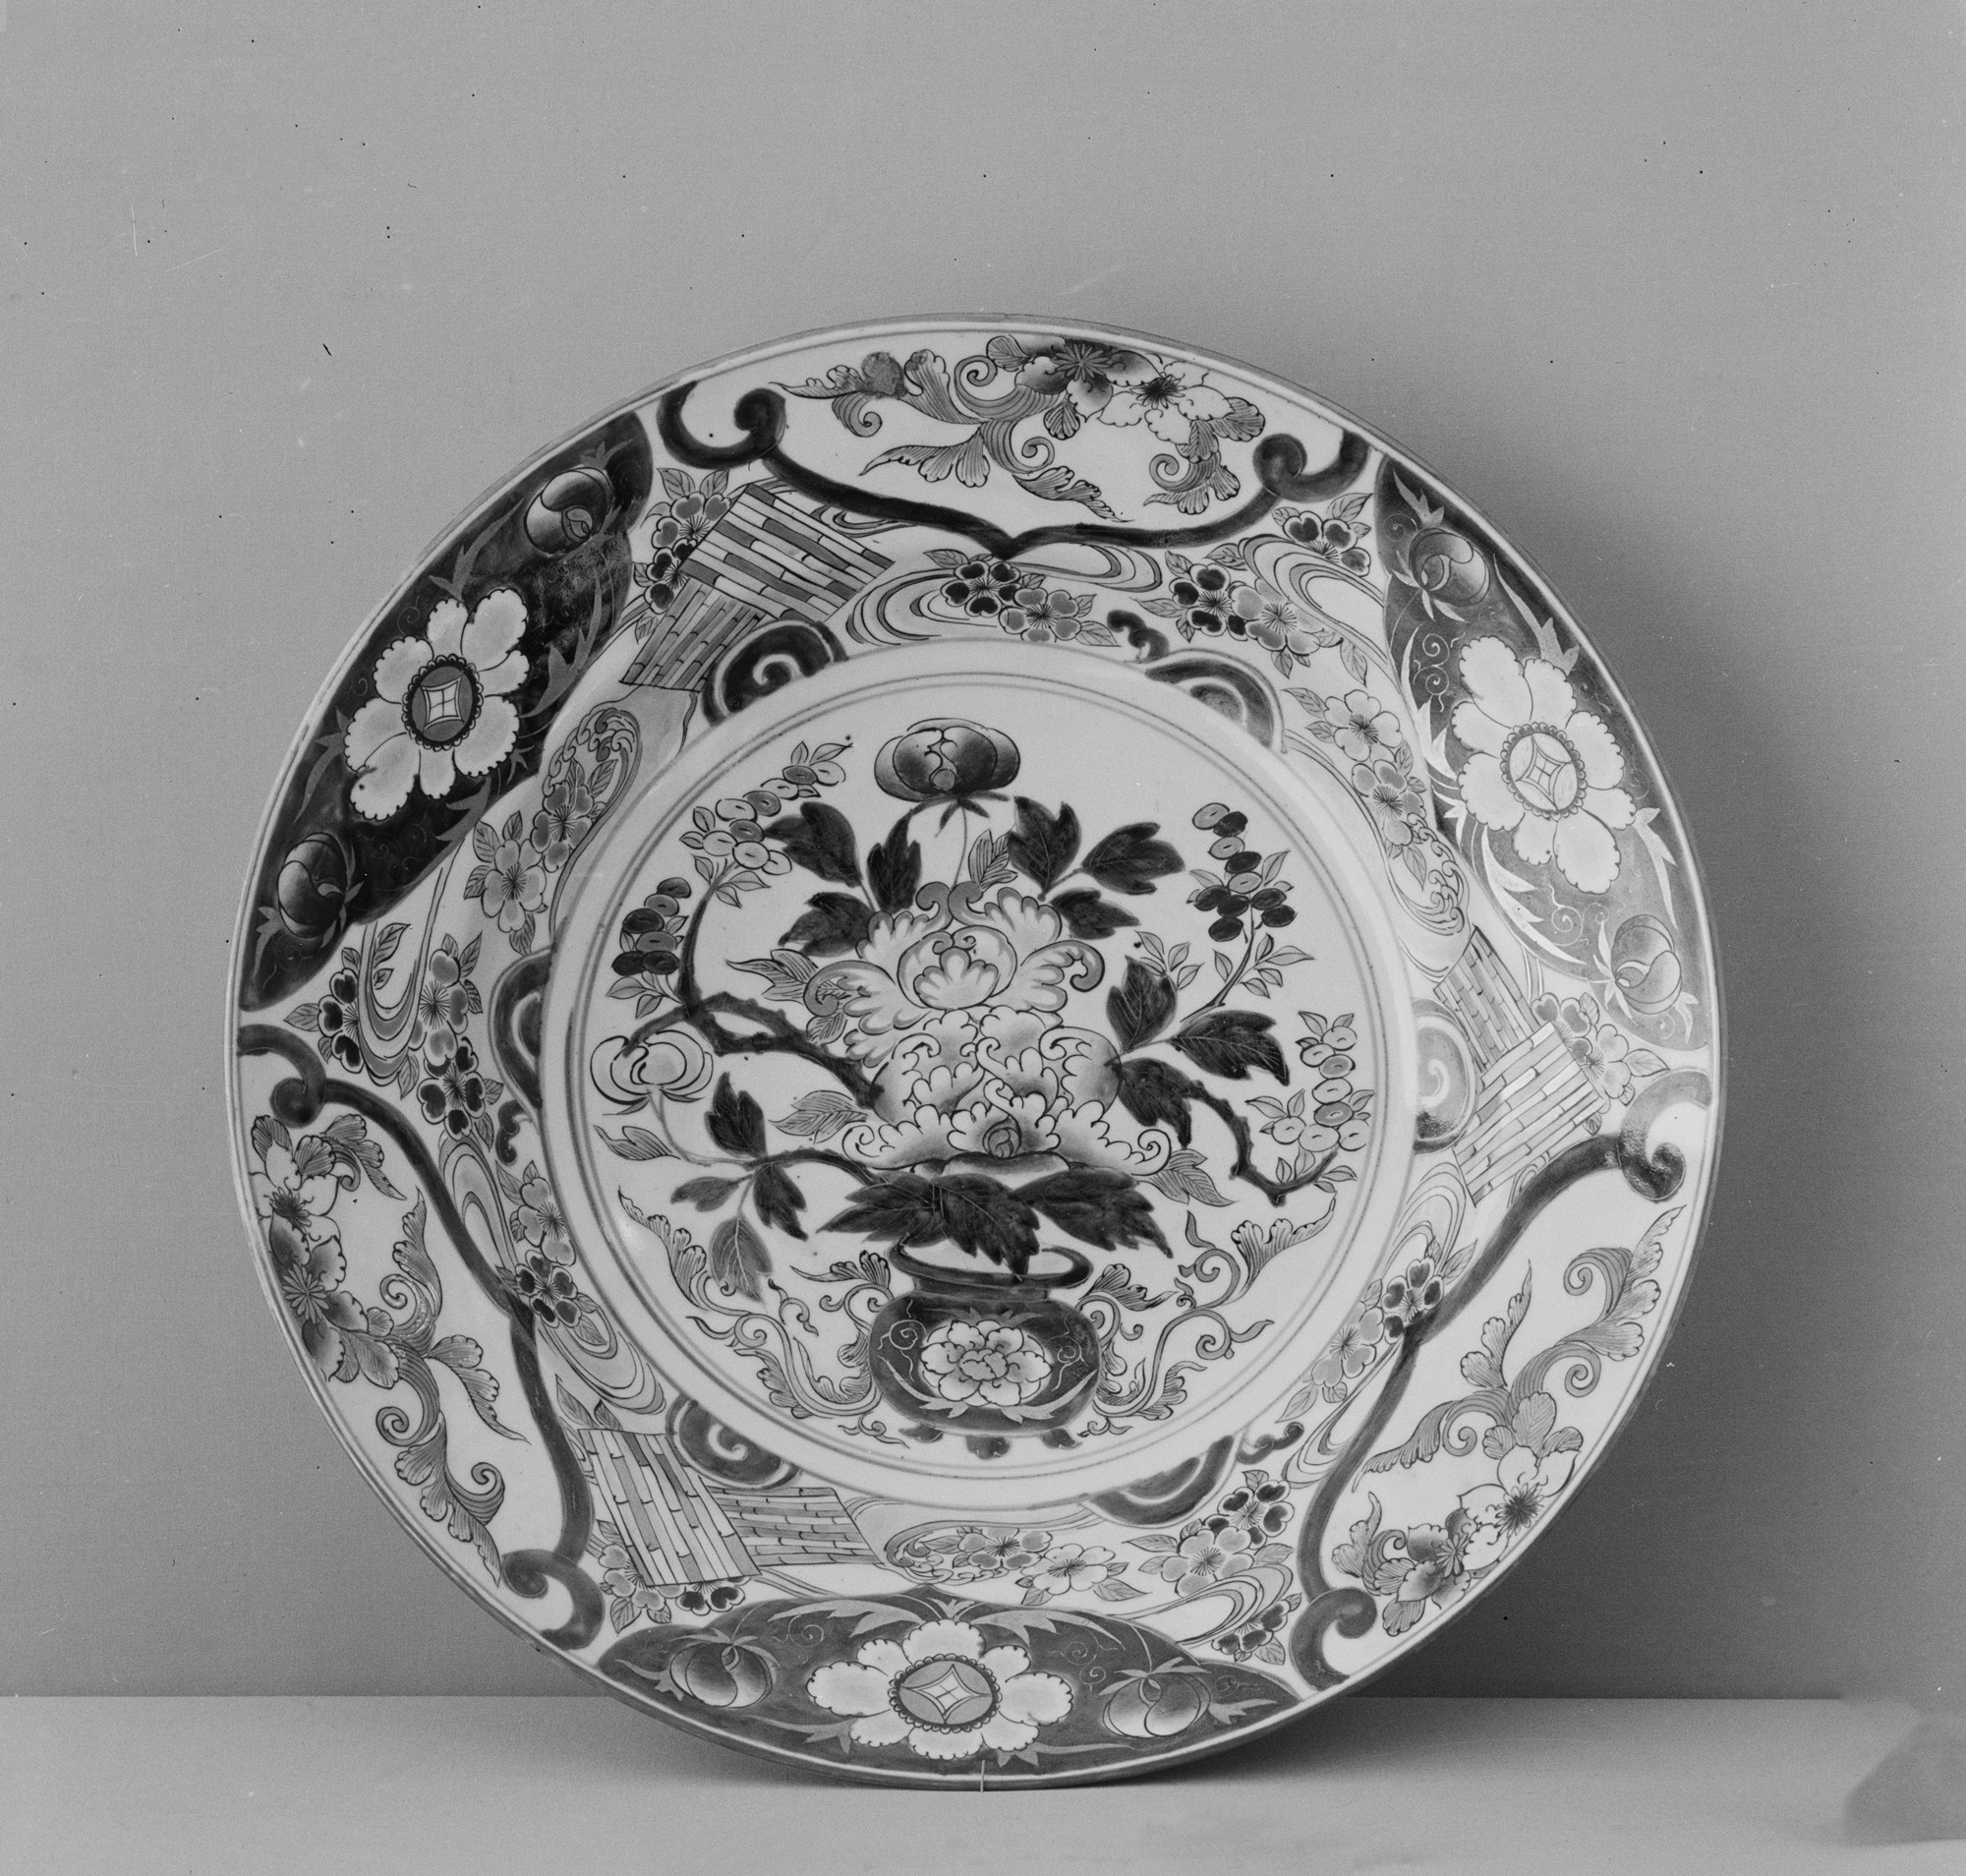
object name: plate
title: Large Dish with Peony Bouquet and Cherry Blossom Rafts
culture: japanese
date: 1667-1733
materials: enamel, gold, porcelain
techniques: overglaze, polychrome, underglaze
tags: peonies